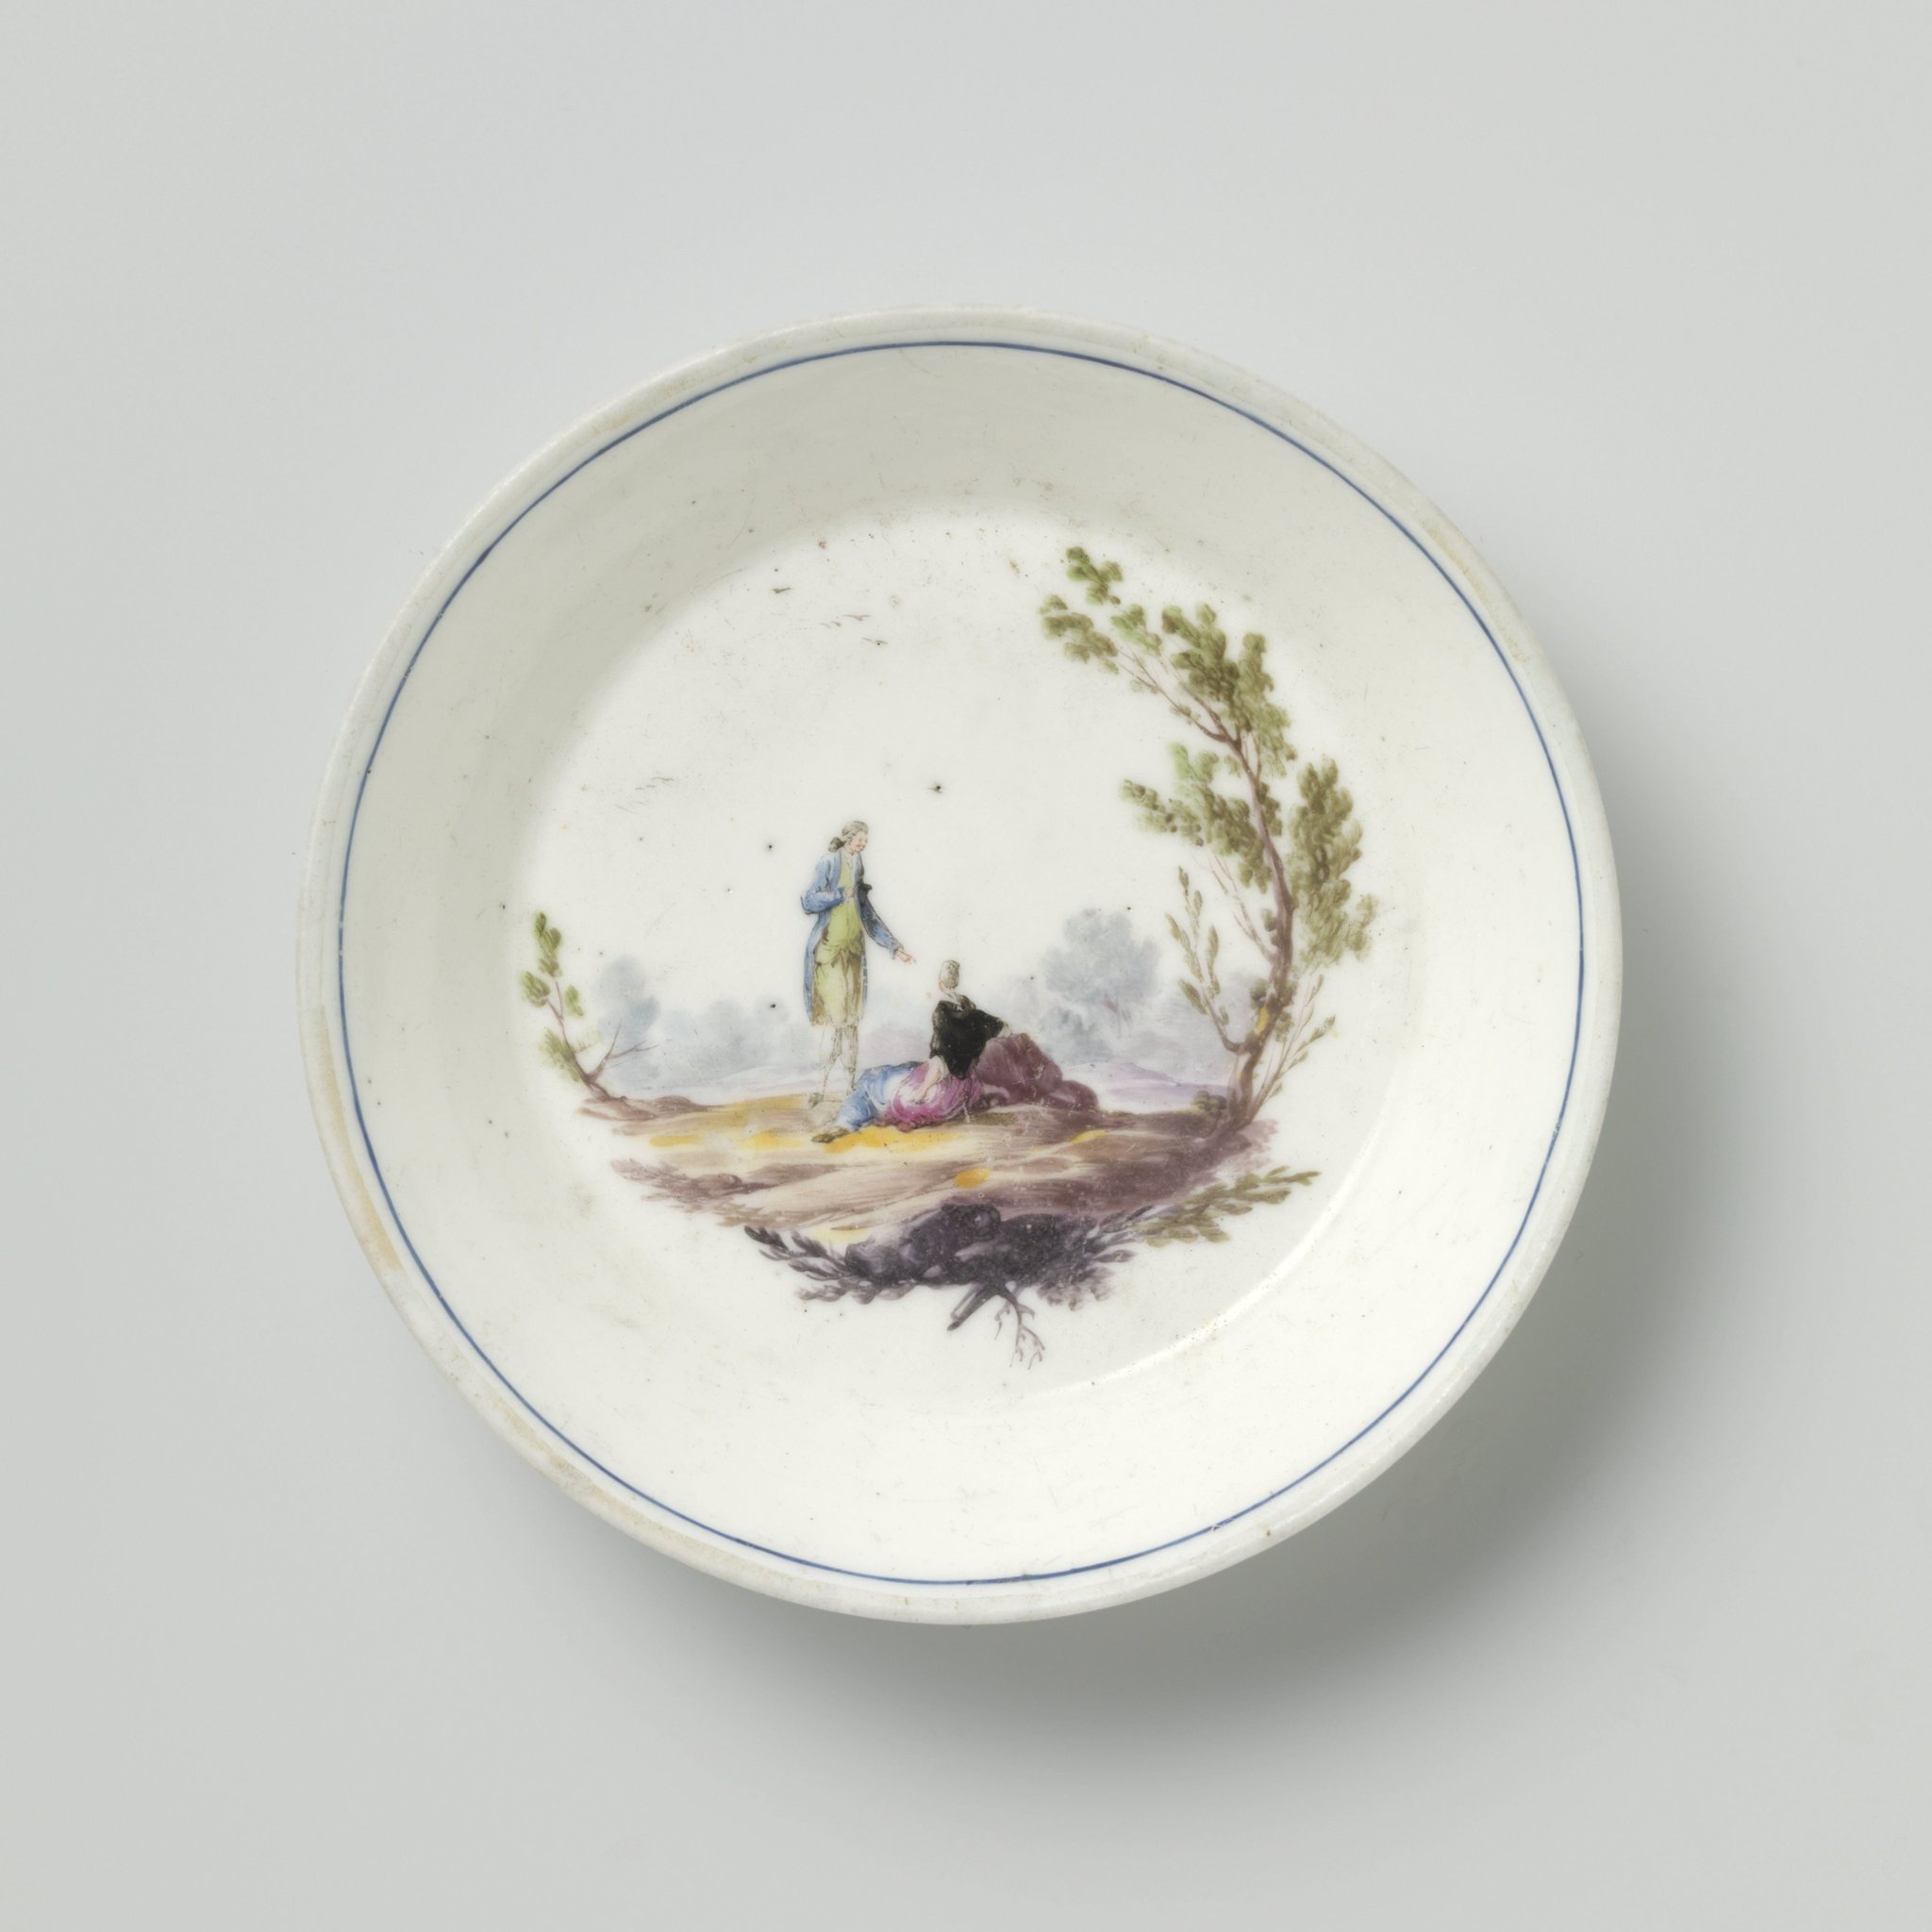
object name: platter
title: Saucer with a couple in a landscape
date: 1770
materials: glaze, gold, paint, porcelain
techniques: firing, forming, gilding, vitrification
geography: mennecy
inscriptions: mark: ‘SX’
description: Schotel van soft-paste porselein (pâte tendre) met een rechte wand, beschilderd in emailkleuren en goud. Op het plat een landschap met daarin een paar. De vrouw zit op de grond, leunend tegen een rots en kijkt op naar de staande man voor haar. Blauwe lijn op de wand. Afgesleten gouden rand. Gemerkt op de onderzijde met SX.